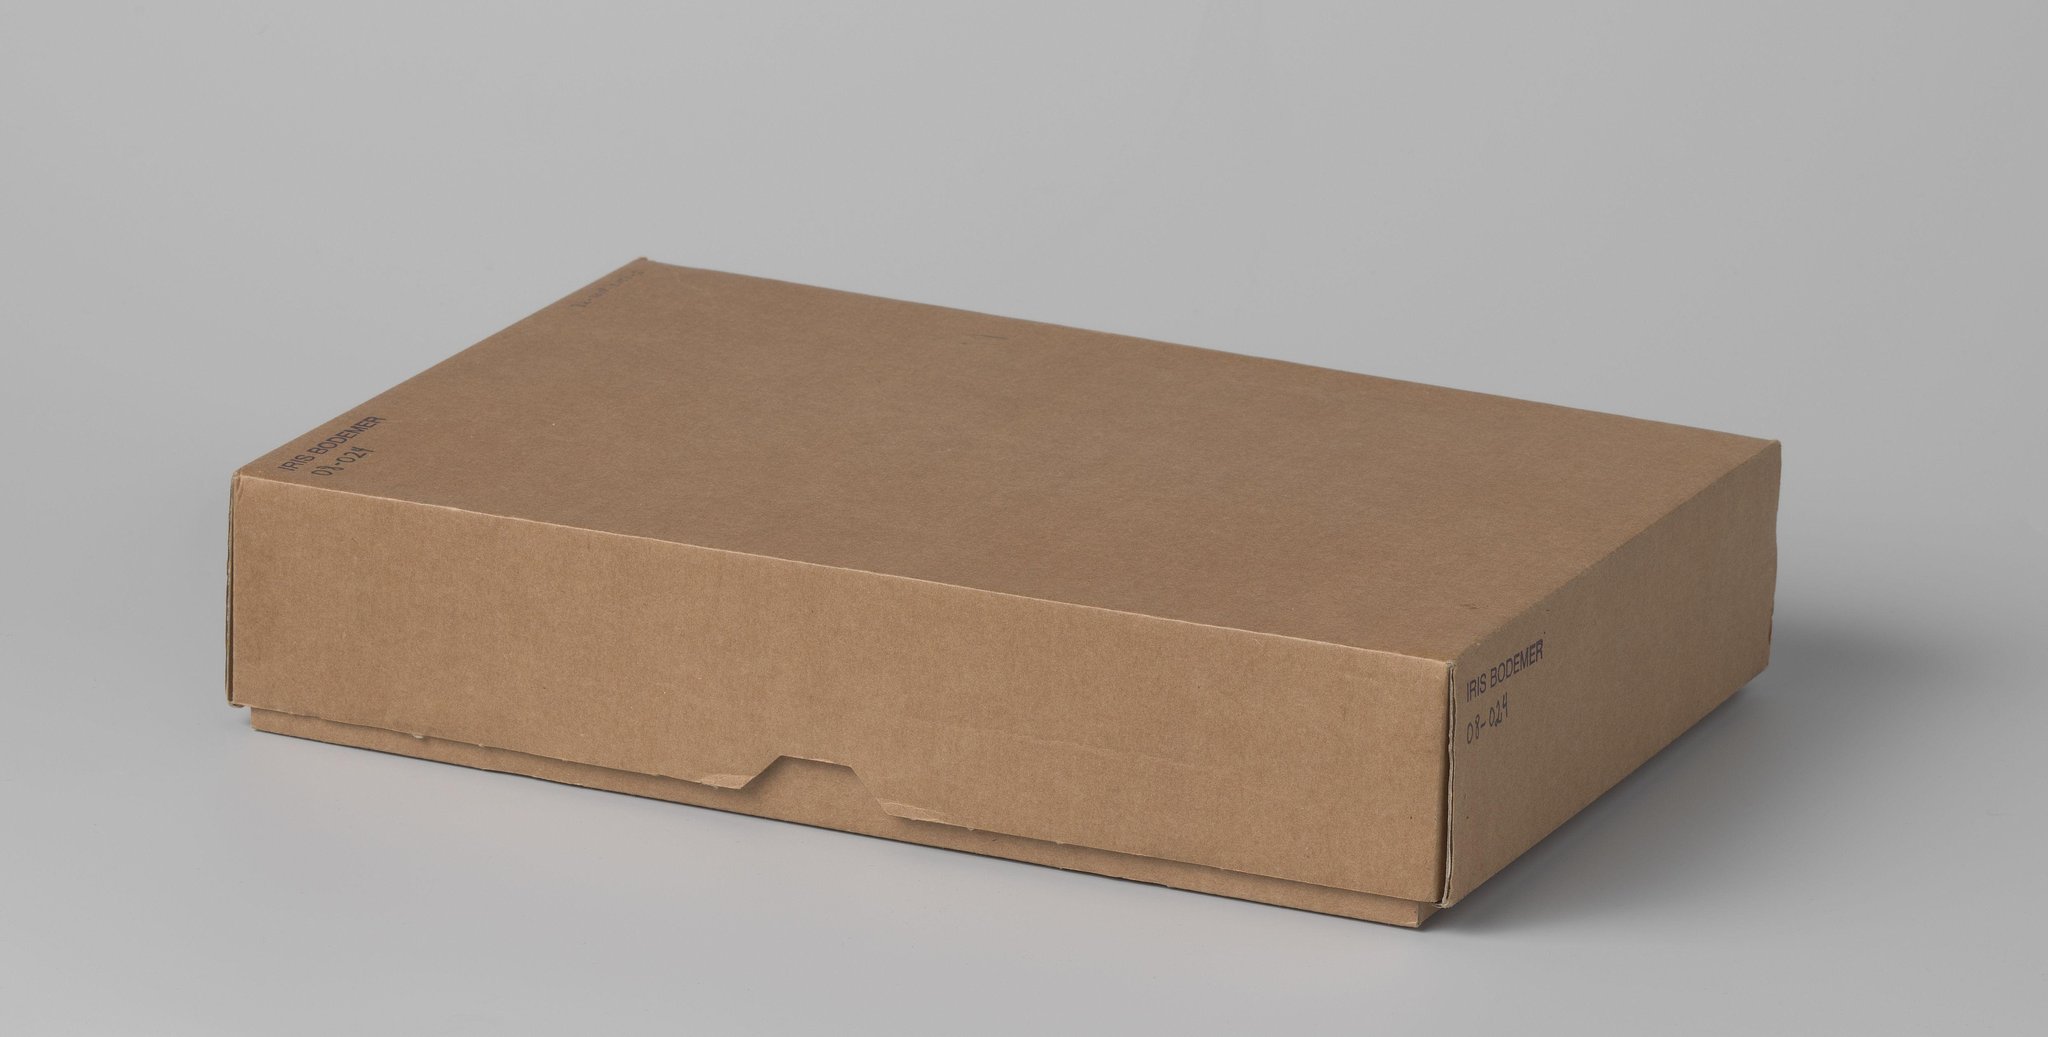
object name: box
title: Rechthoekige doos van karton met los deksel en grijs schuimrubber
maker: iris bodemer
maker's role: designer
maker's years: 1970-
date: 2010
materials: cardboard, rubber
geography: germany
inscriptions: number: ‘08-024’, name: ‘IRIS BODEMER’